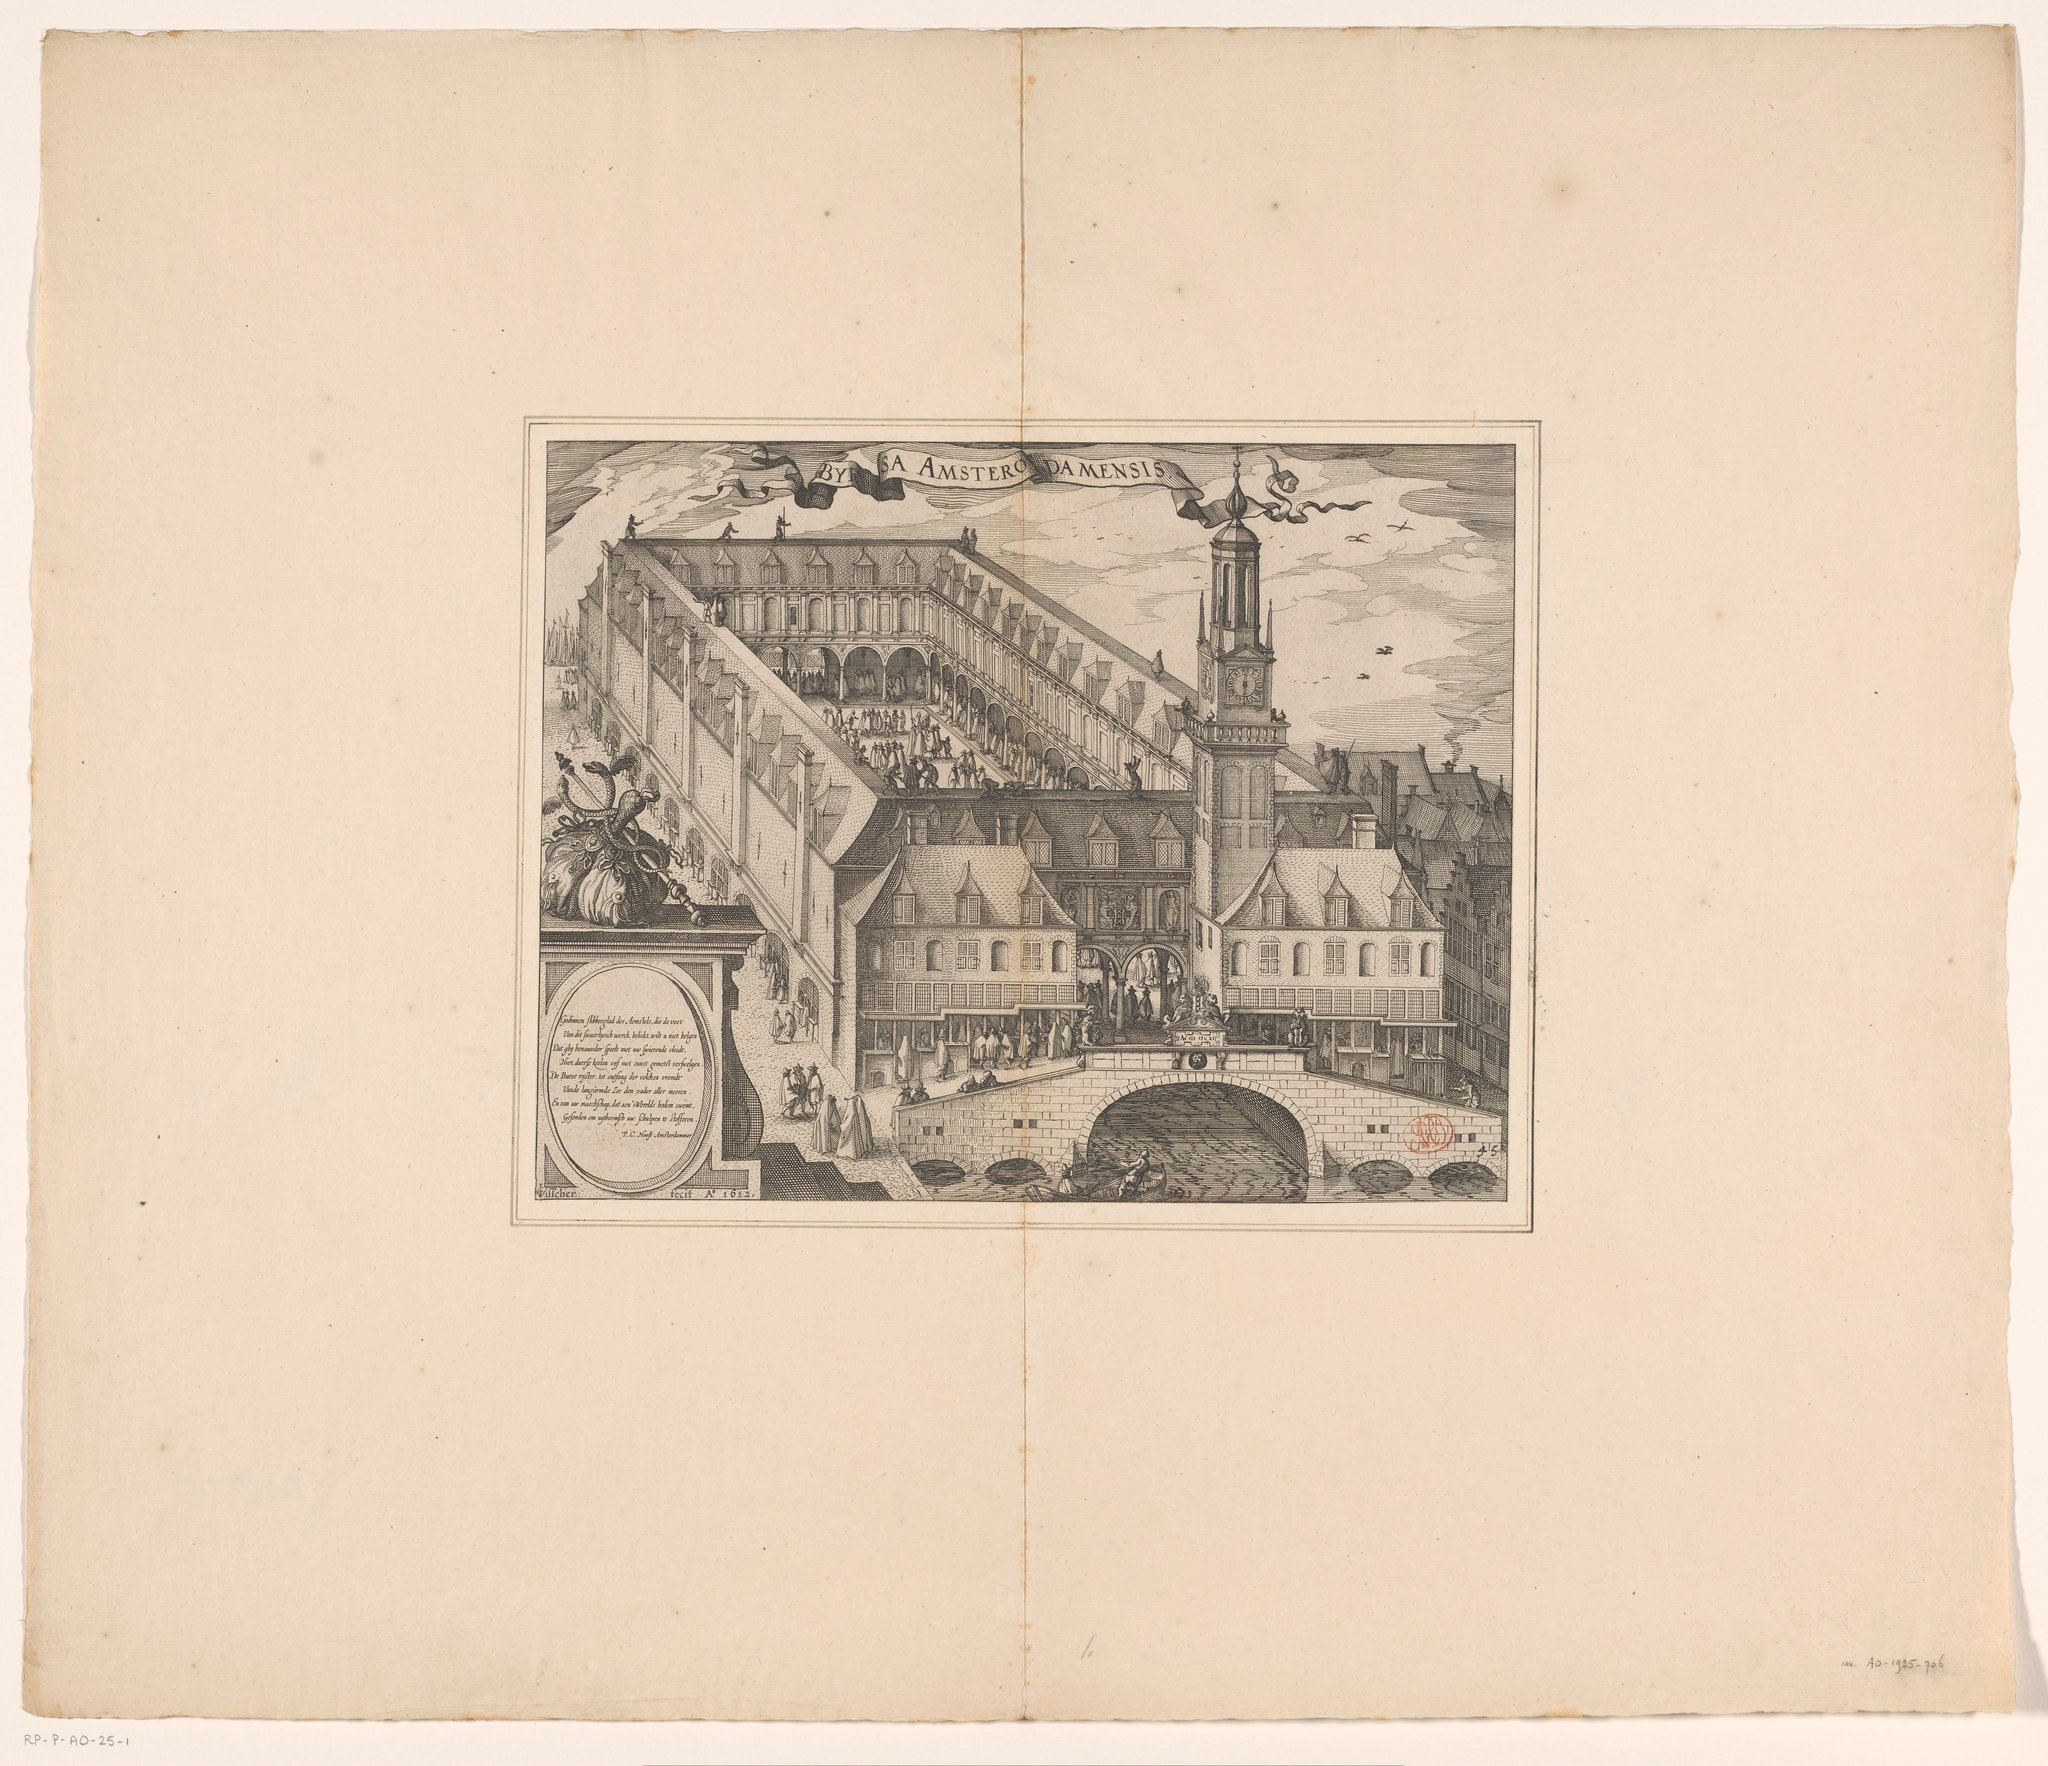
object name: book illustration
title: Vogelvluchtgezicht op de Beurs van Hendrik de Keyser te Amsterdam, voor 1668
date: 1613-1648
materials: paper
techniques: engraving, etching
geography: amsterdam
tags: purse, money-bag, stock exchange, stock-market, caduceus (staff with two snakes, attribute of mercury), street (+ city(-scape) with figures, staffage)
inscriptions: collector's mark: Lugt 195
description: Deze staat van prent voor het eerst ook gebruikt in: Guicciardini, Lodovico. Beschryvinghe van alle de Neder-landen, anderssins ghenoemt Neder-Duytslandt (…). Amsterdam: Willem Janszoon Blaeu, 1613. Hierna is deze prent tot 1648 nog gebruikt in latere uitgaven van deze publicatie, uitgegeven door Blaeu en daarna door Janssonius. Uit welke uitgave het huidige exemplaar precies komt is niet na te gaan.